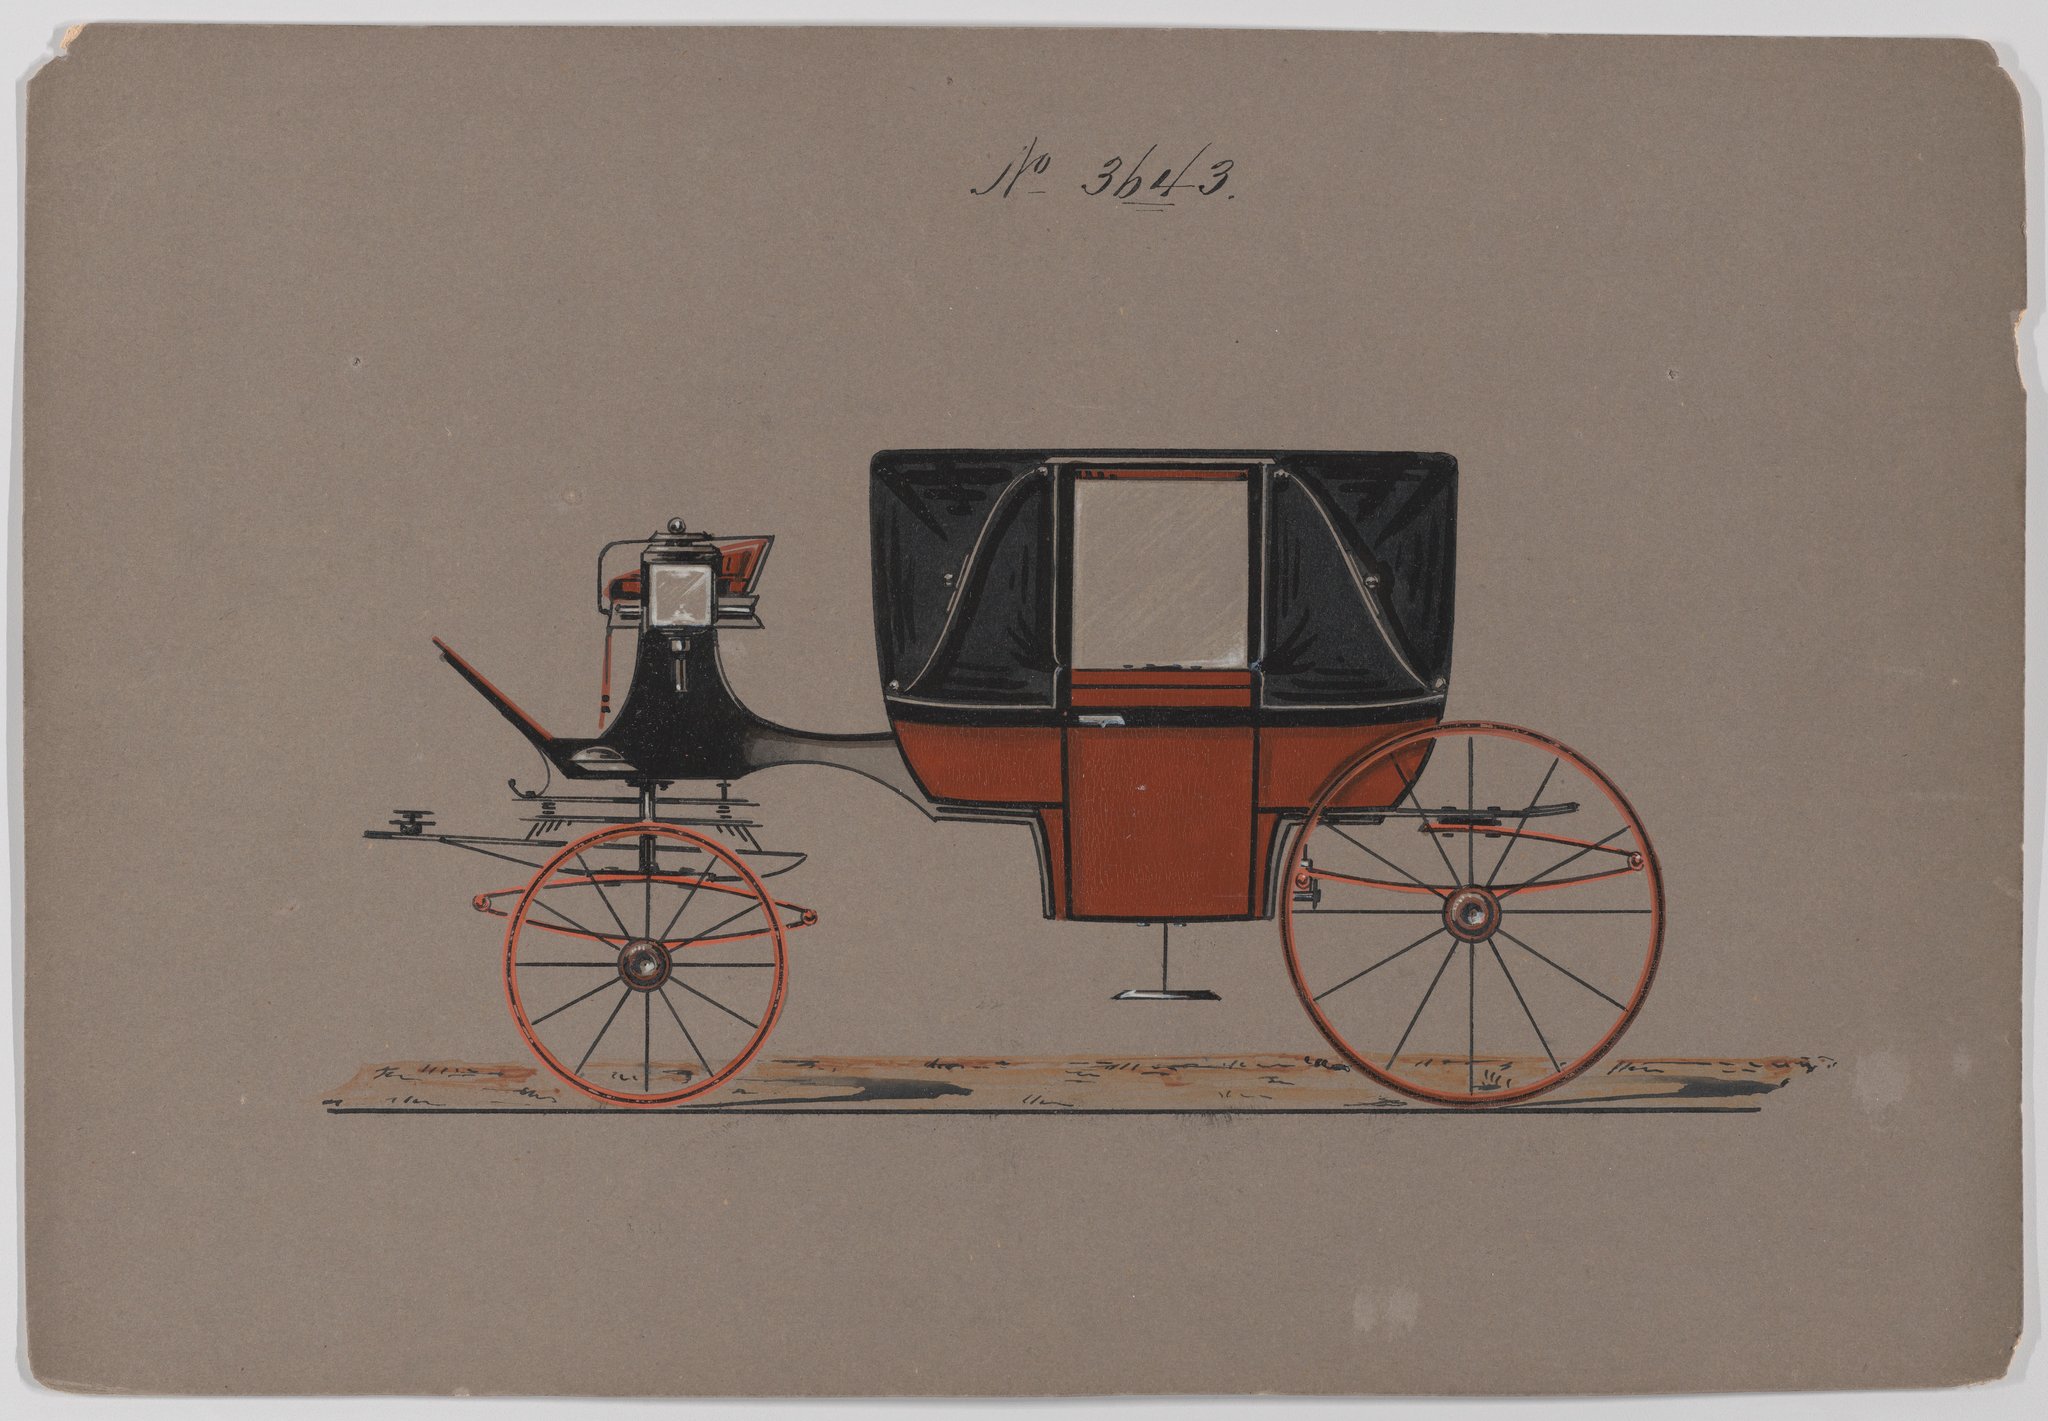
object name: drawing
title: Design for Landau, No. 3643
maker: brewster & co.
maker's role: manufacturer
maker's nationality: american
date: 1880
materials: gouache, gum arabic, ink, watercolor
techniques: pen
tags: carriages